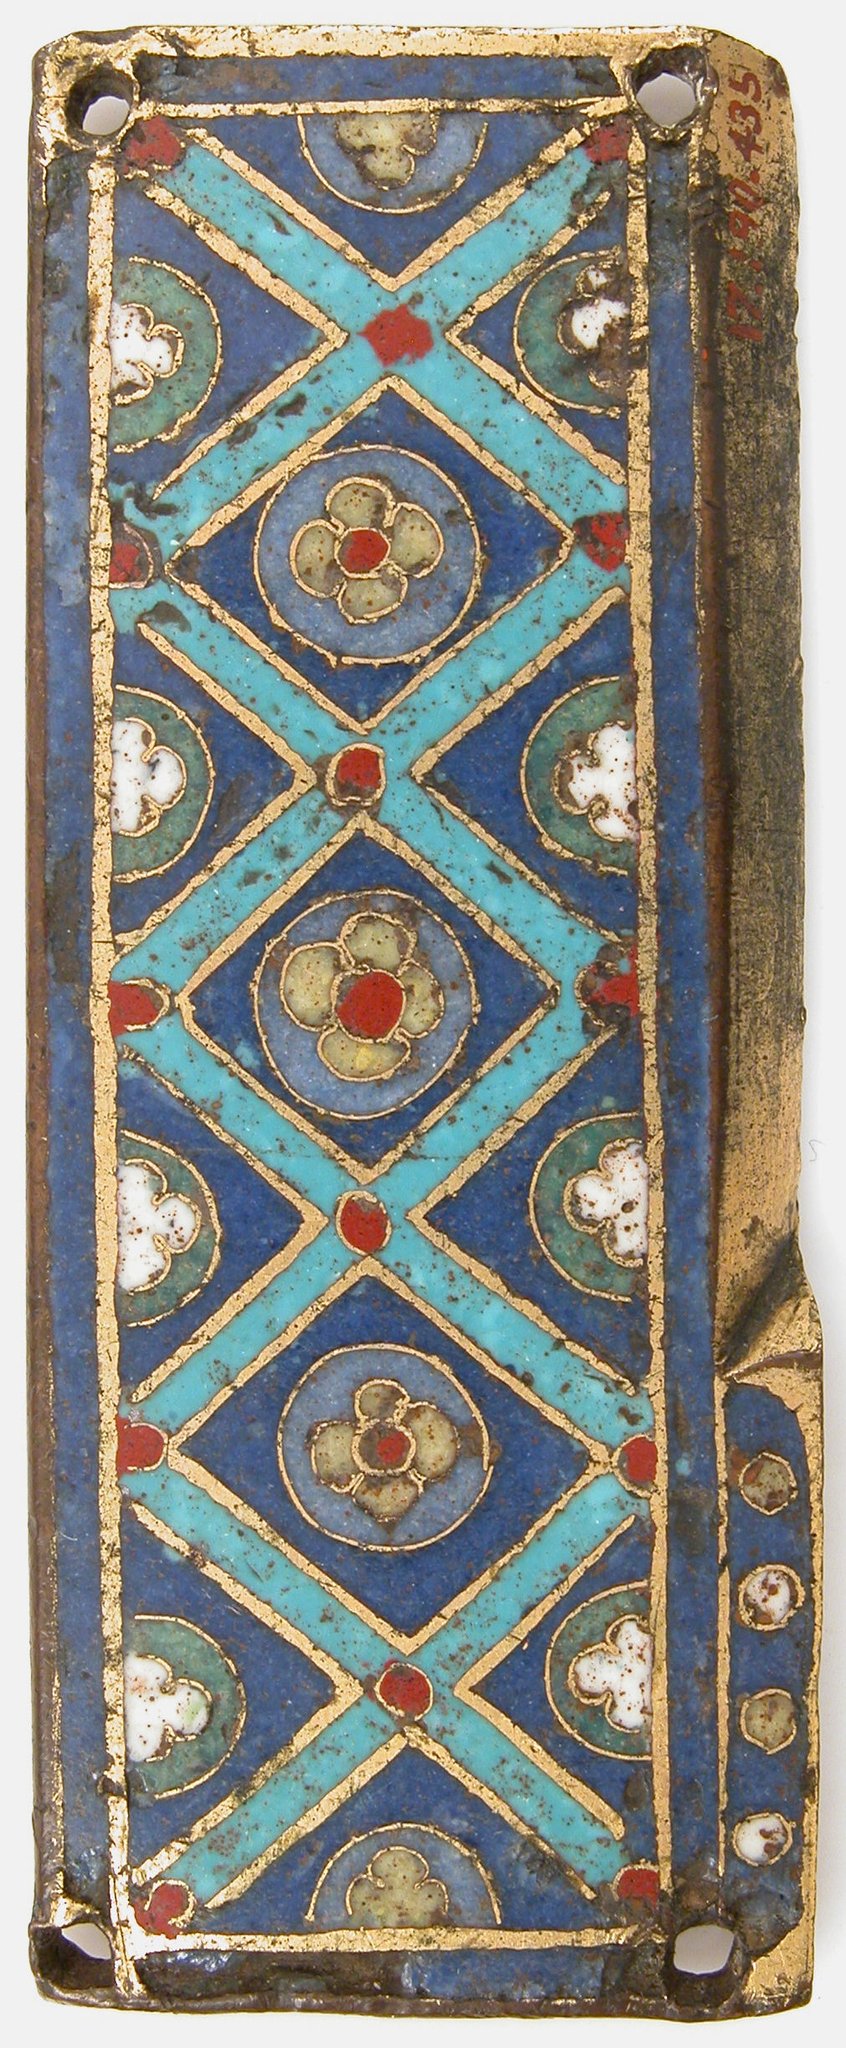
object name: plaque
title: Plaque from a Reliquary Shrine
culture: german or south netherlandish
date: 1175-1200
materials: copper alloy, enamel, gilt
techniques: enamel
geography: meuse valley